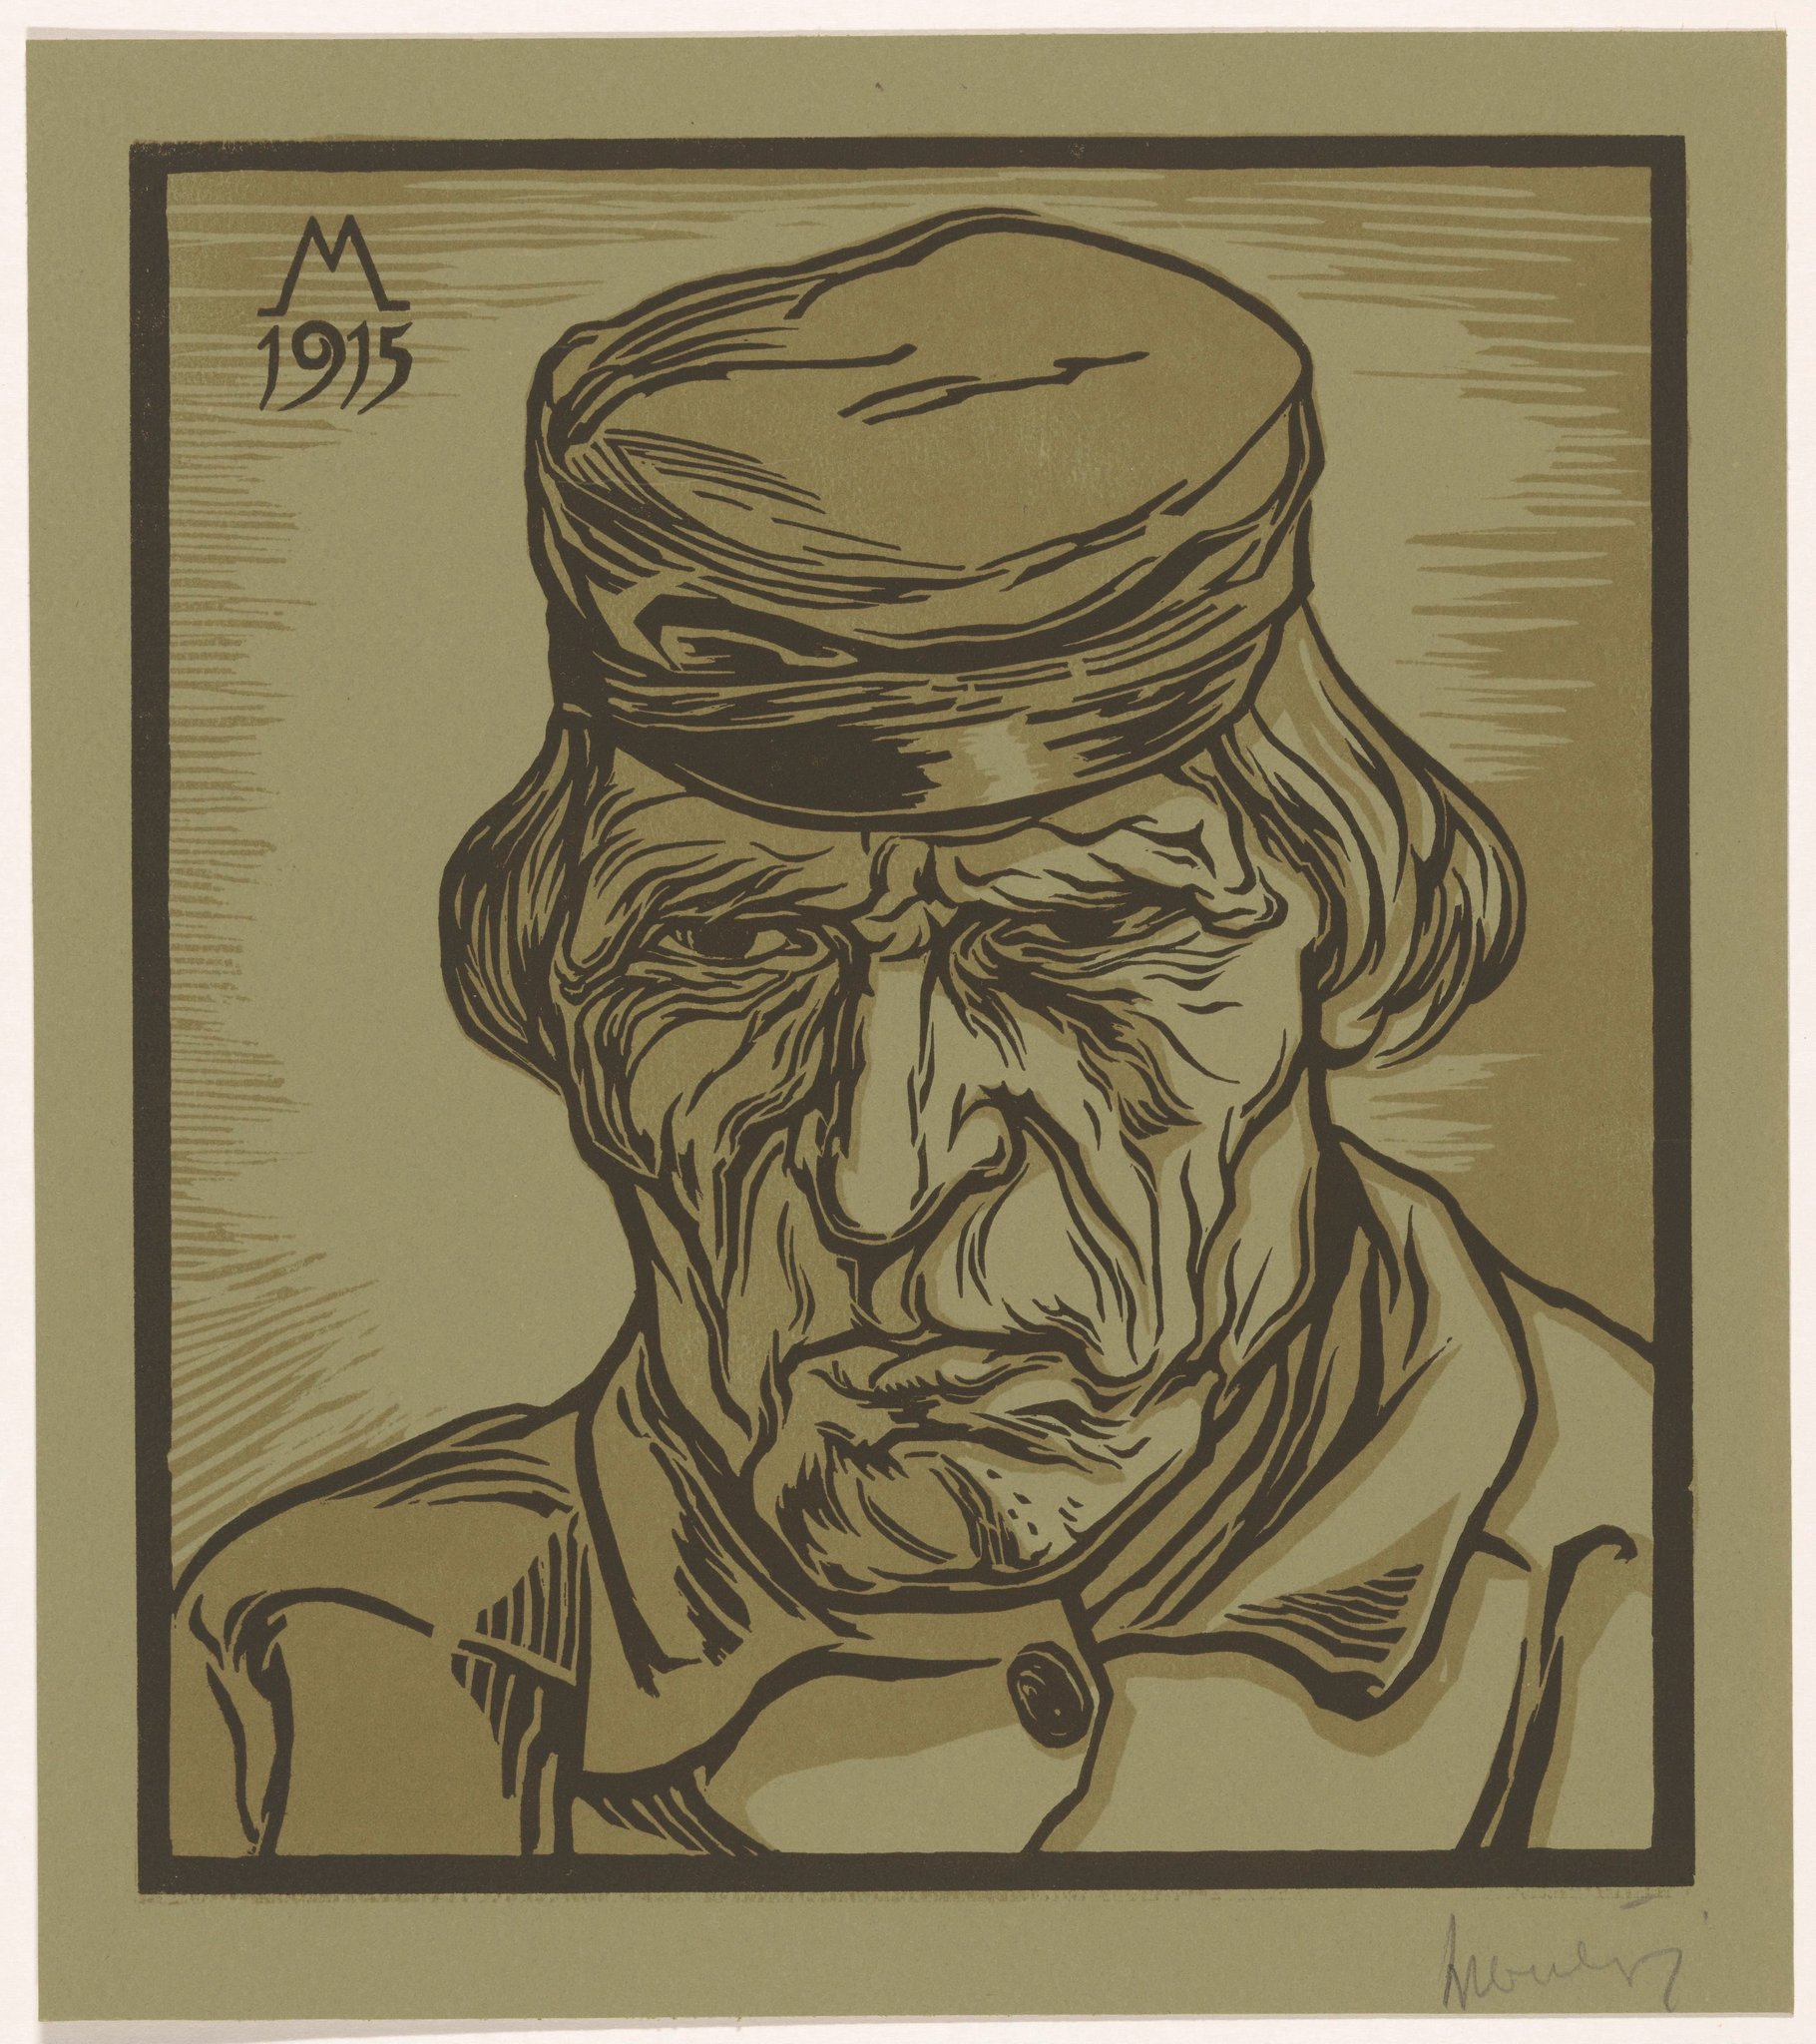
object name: print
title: Portret van een Zeeuwse boer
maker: simon moulijn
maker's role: draughtsman, print maker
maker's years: 1866-1948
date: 1915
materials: paper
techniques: woodcut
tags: historical persons, farmers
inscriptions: collector's mark: Lugt 2228